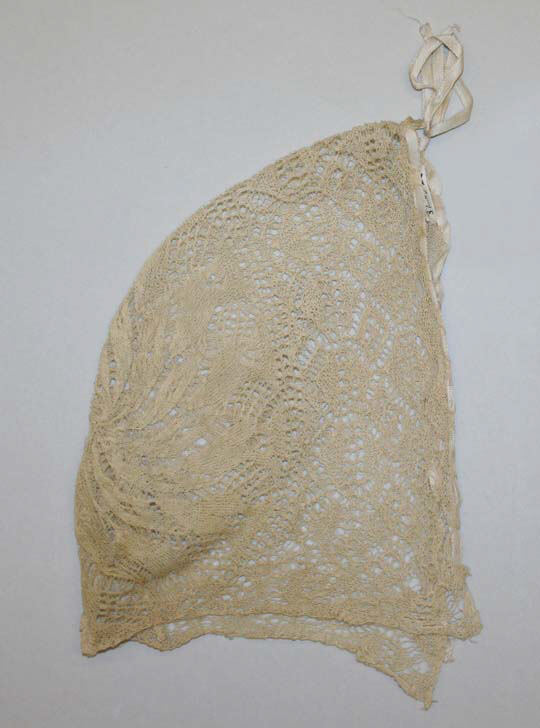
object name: cap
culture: american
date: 1700-1937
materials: cotton, silk